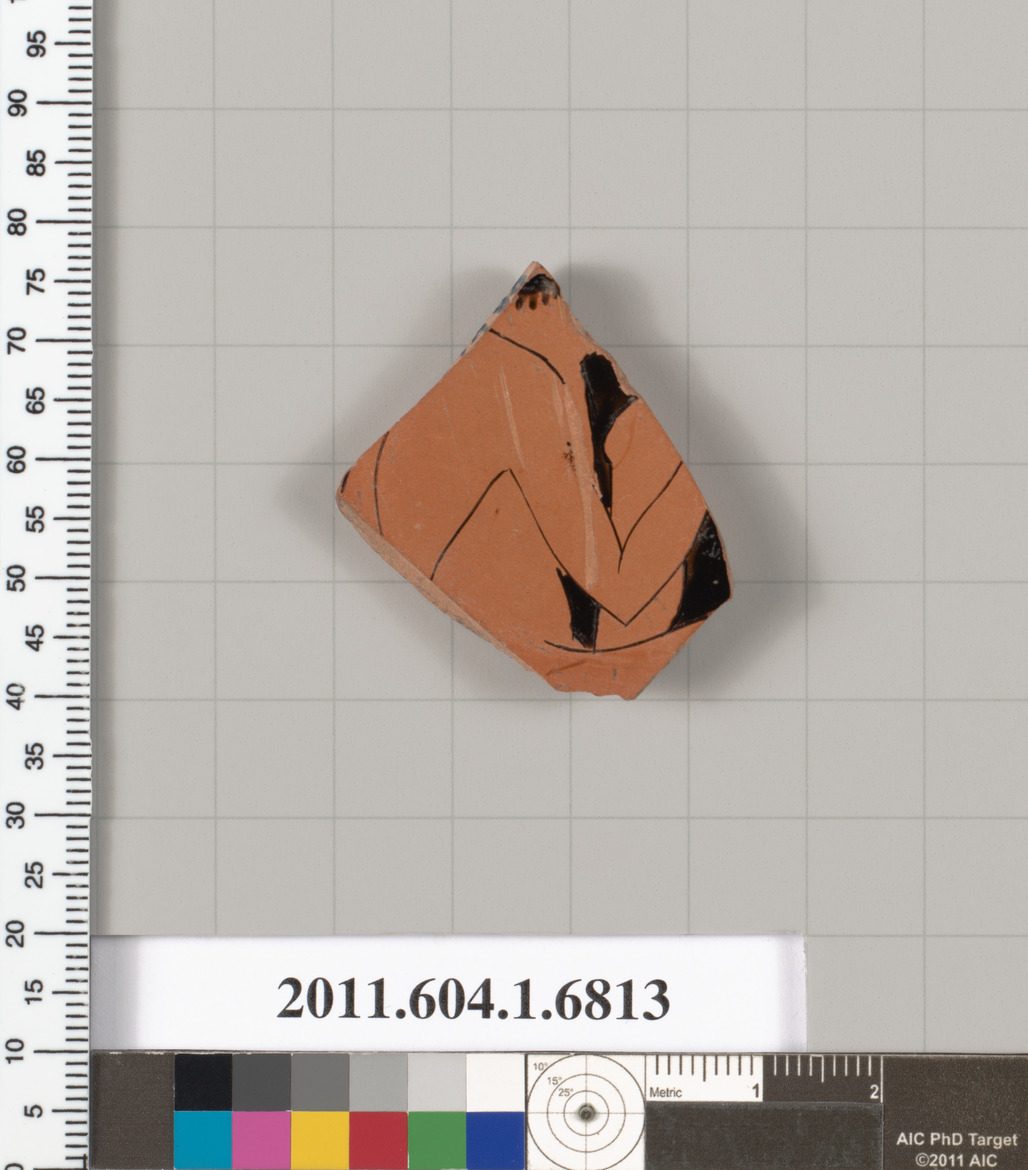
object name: kylix fragment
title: Terracotta fragment of a kylix (drinking cup)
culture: greek, attic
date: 490-470 BCE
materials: terracotta